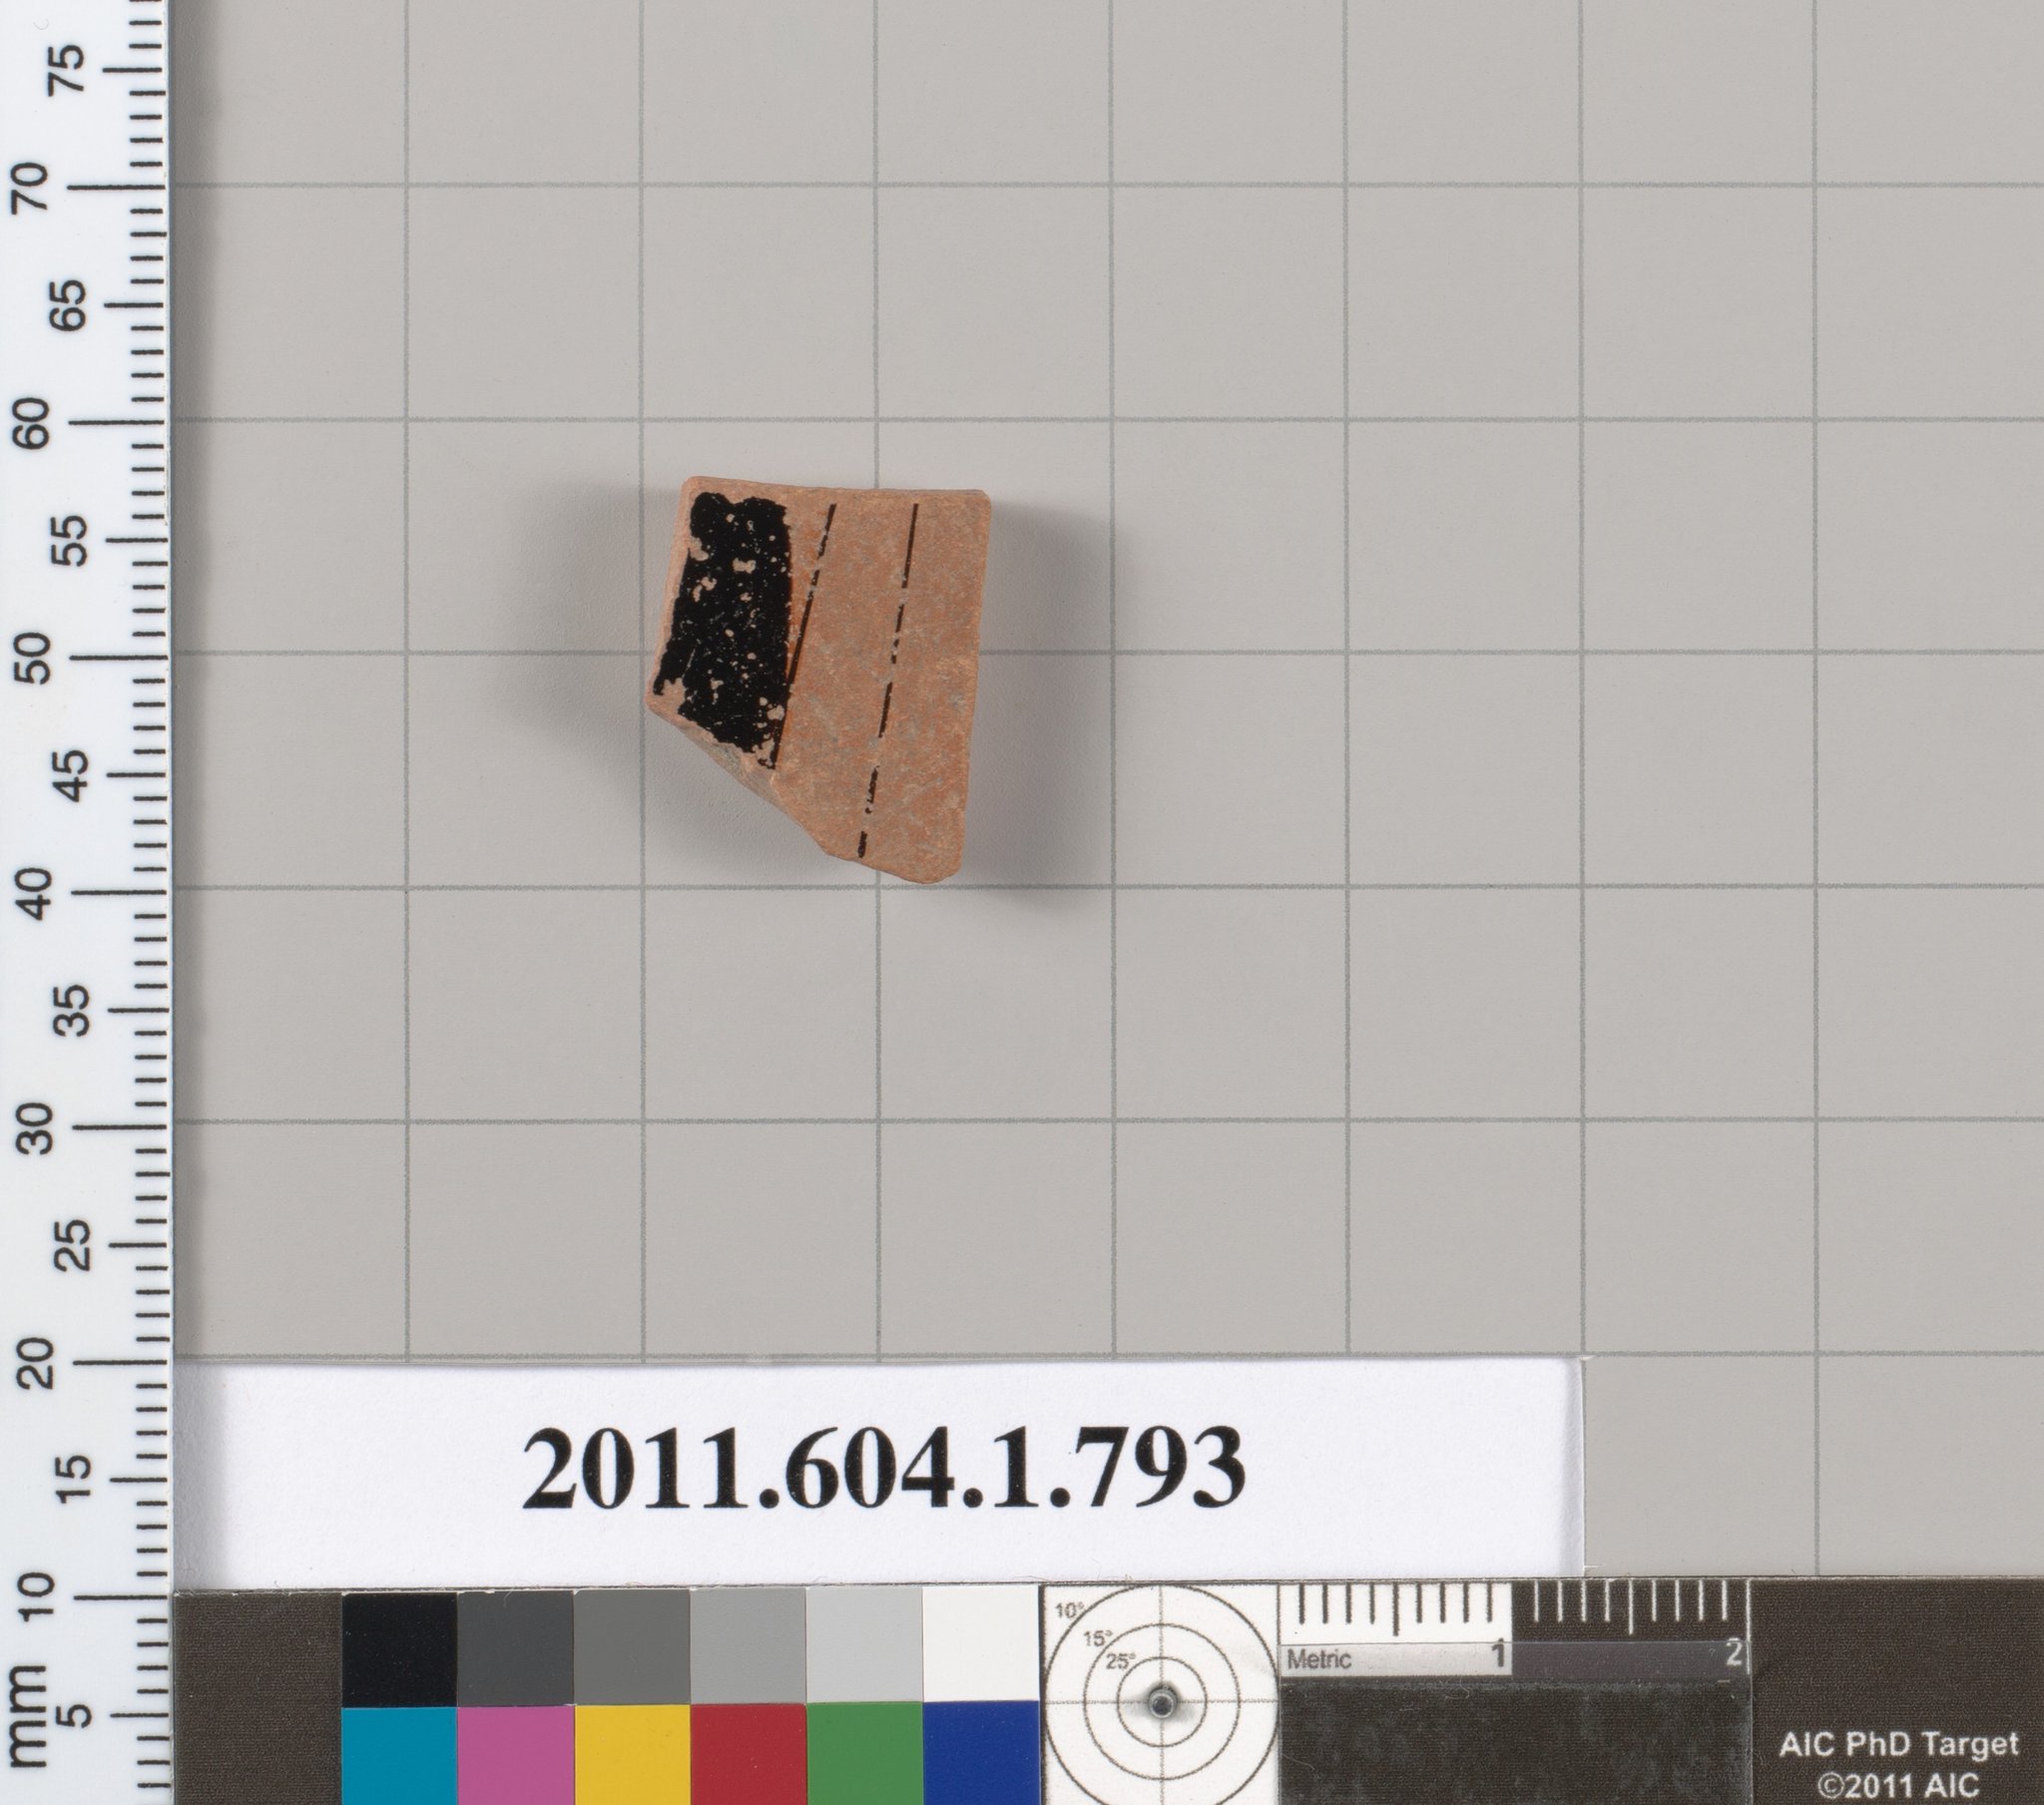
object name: kylix fragment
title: Terracotta fragment of a kylix (drinking cup)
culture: greek, attic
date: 475-451 BCE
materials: terracotta